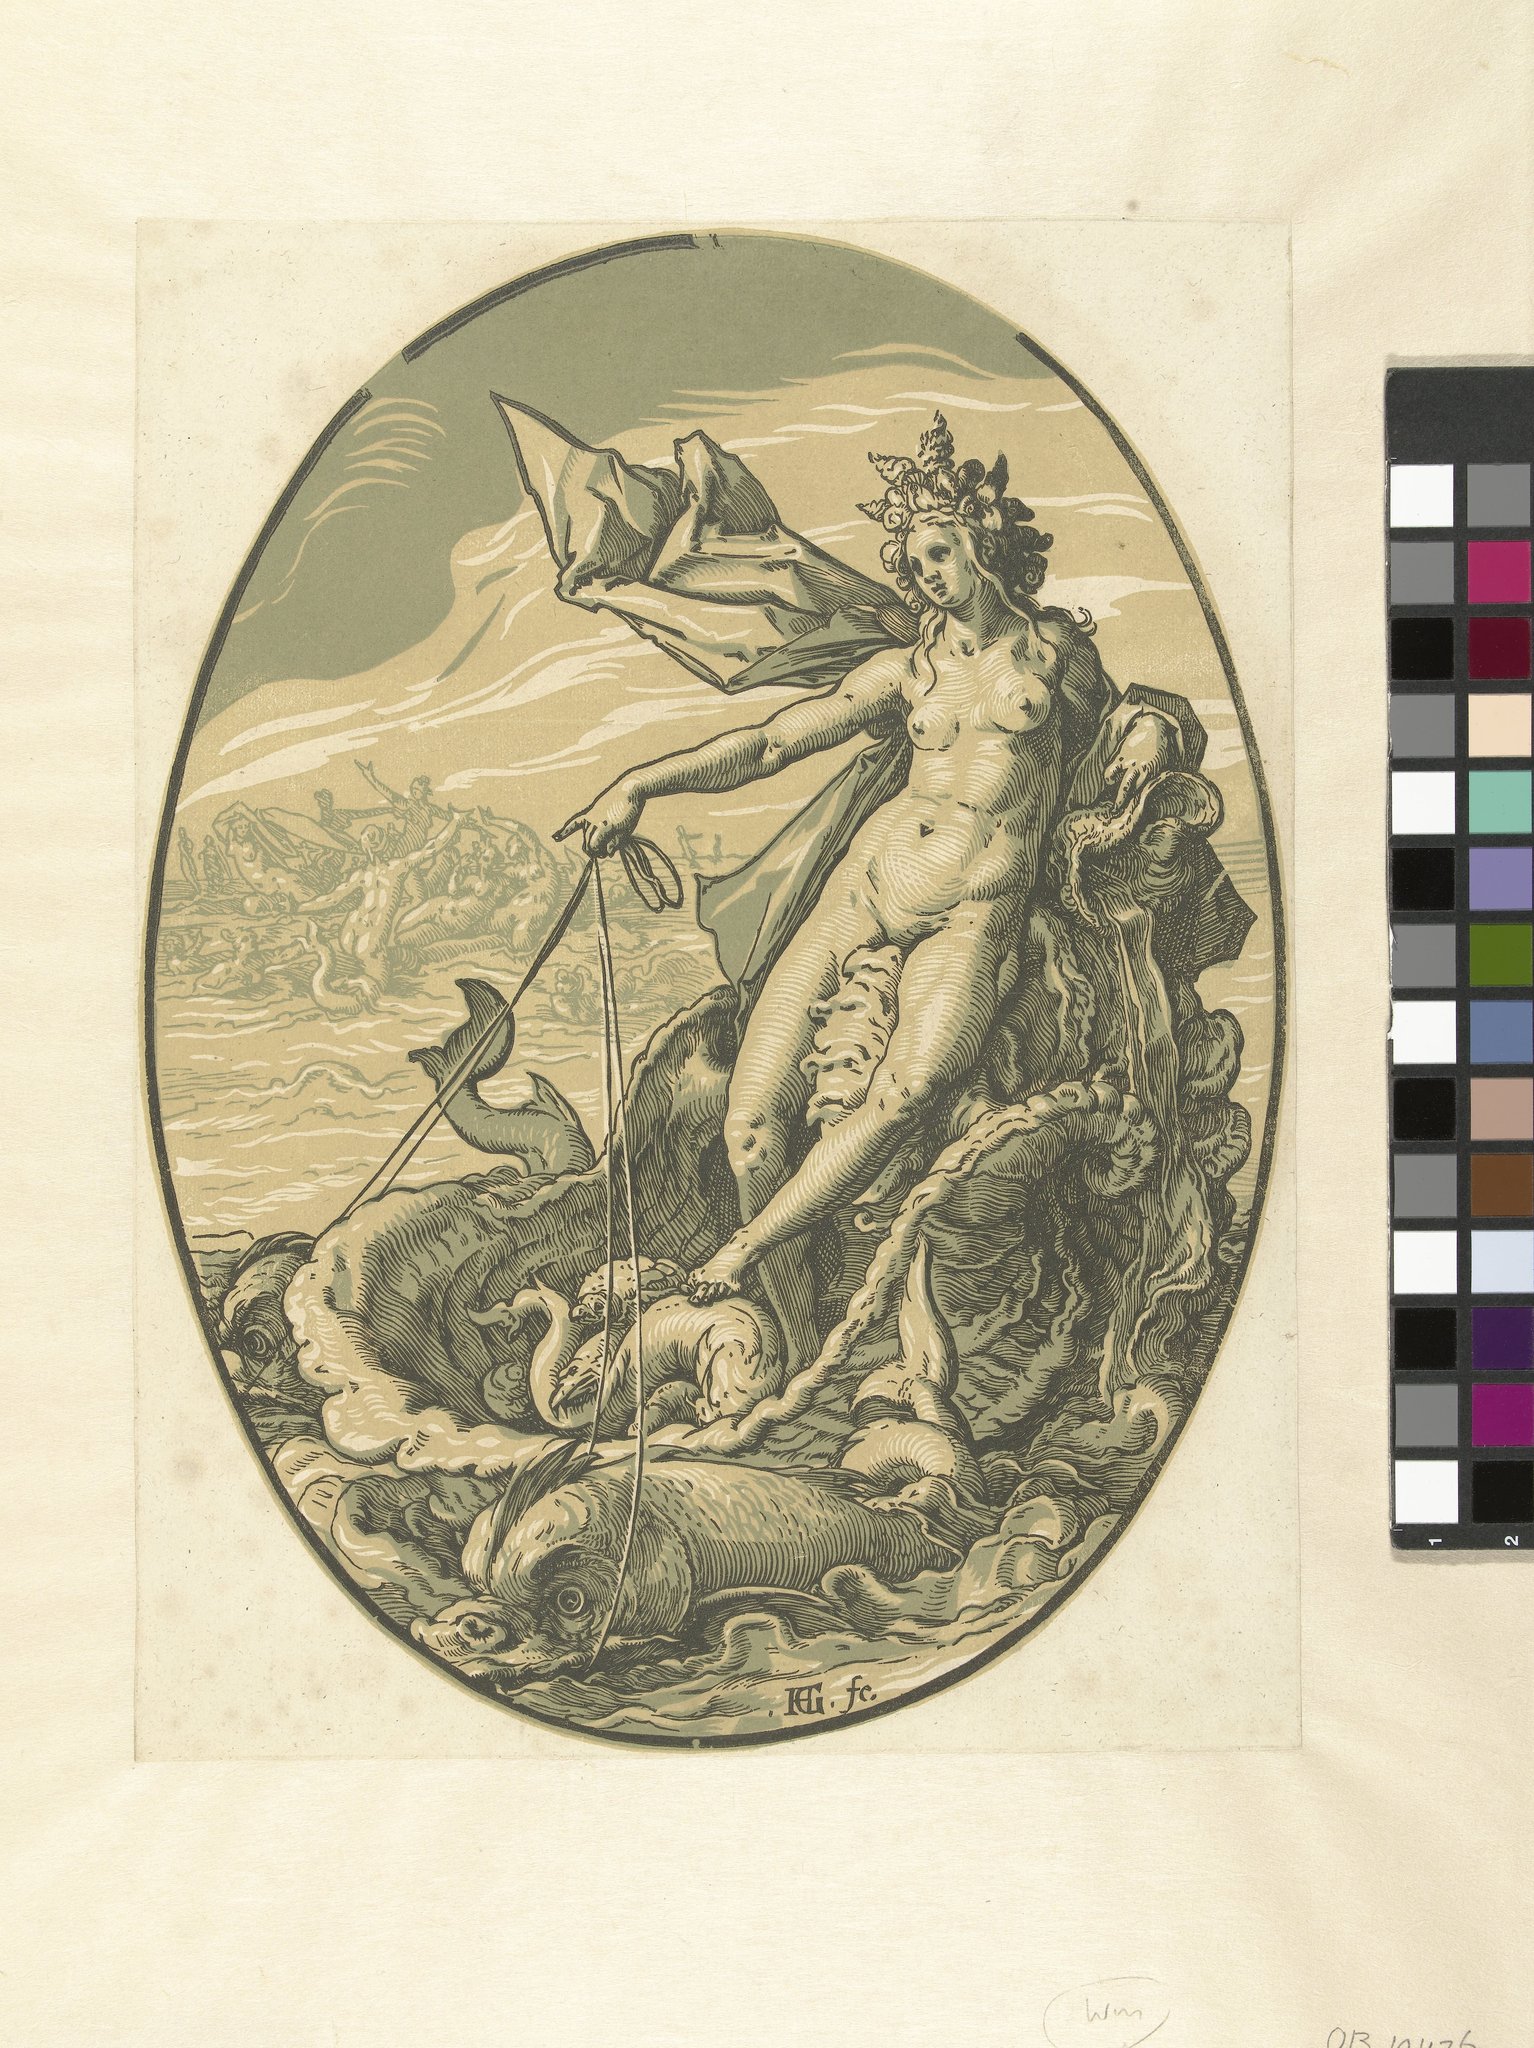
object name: print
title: Goden en godinnen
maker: hendrick goltzius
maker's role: draughtsman, painter, print maker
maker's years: 1558-1617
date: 1589-1590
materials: paper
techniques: woodcut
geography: haarlem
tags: (story of) thetis; 'thethi, ninfa del mare' (ripa)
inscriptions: collector's mark: Lugt 2228a, collector's mark: Lugt 240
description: De godin Thetis, varend op een schelp die getrokken wordt door vissen. Deze prent is onderdeel van een serie van zeven ovale prenten van klassieke goden en godinnen.